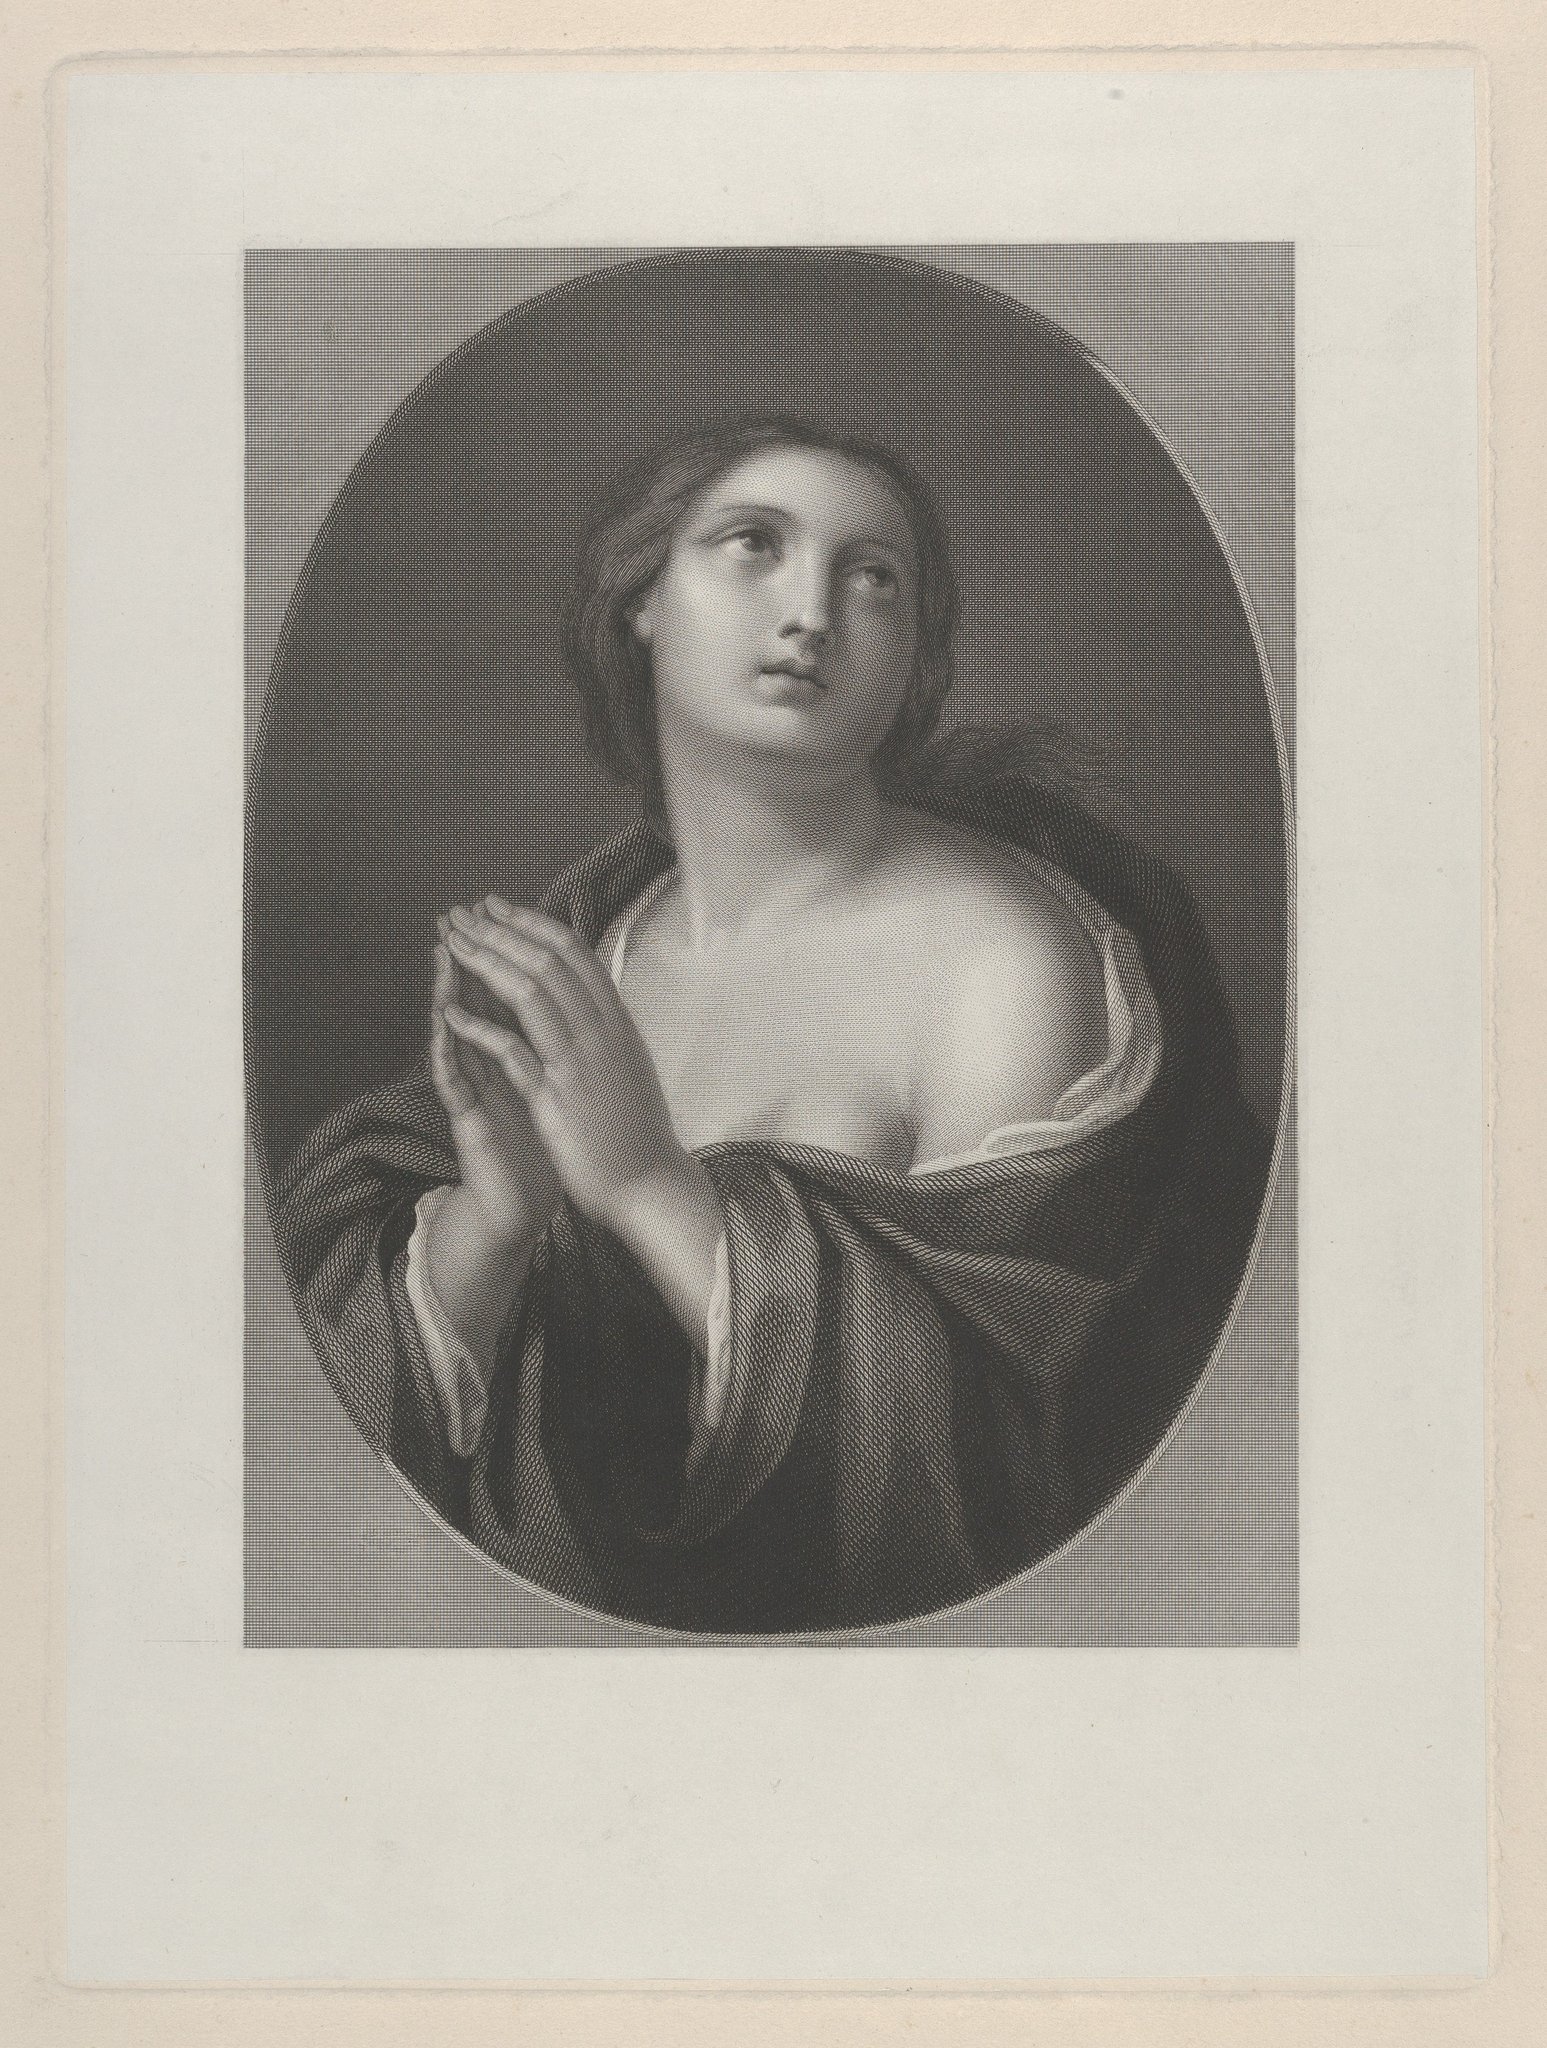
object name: print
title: Female personification of Hope looking up with hands held together and left shoulder exposed, in an oval frame, after Reni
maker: Anonymous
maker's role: artist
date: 1800-1900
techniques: engraving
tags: portraits,women,praying